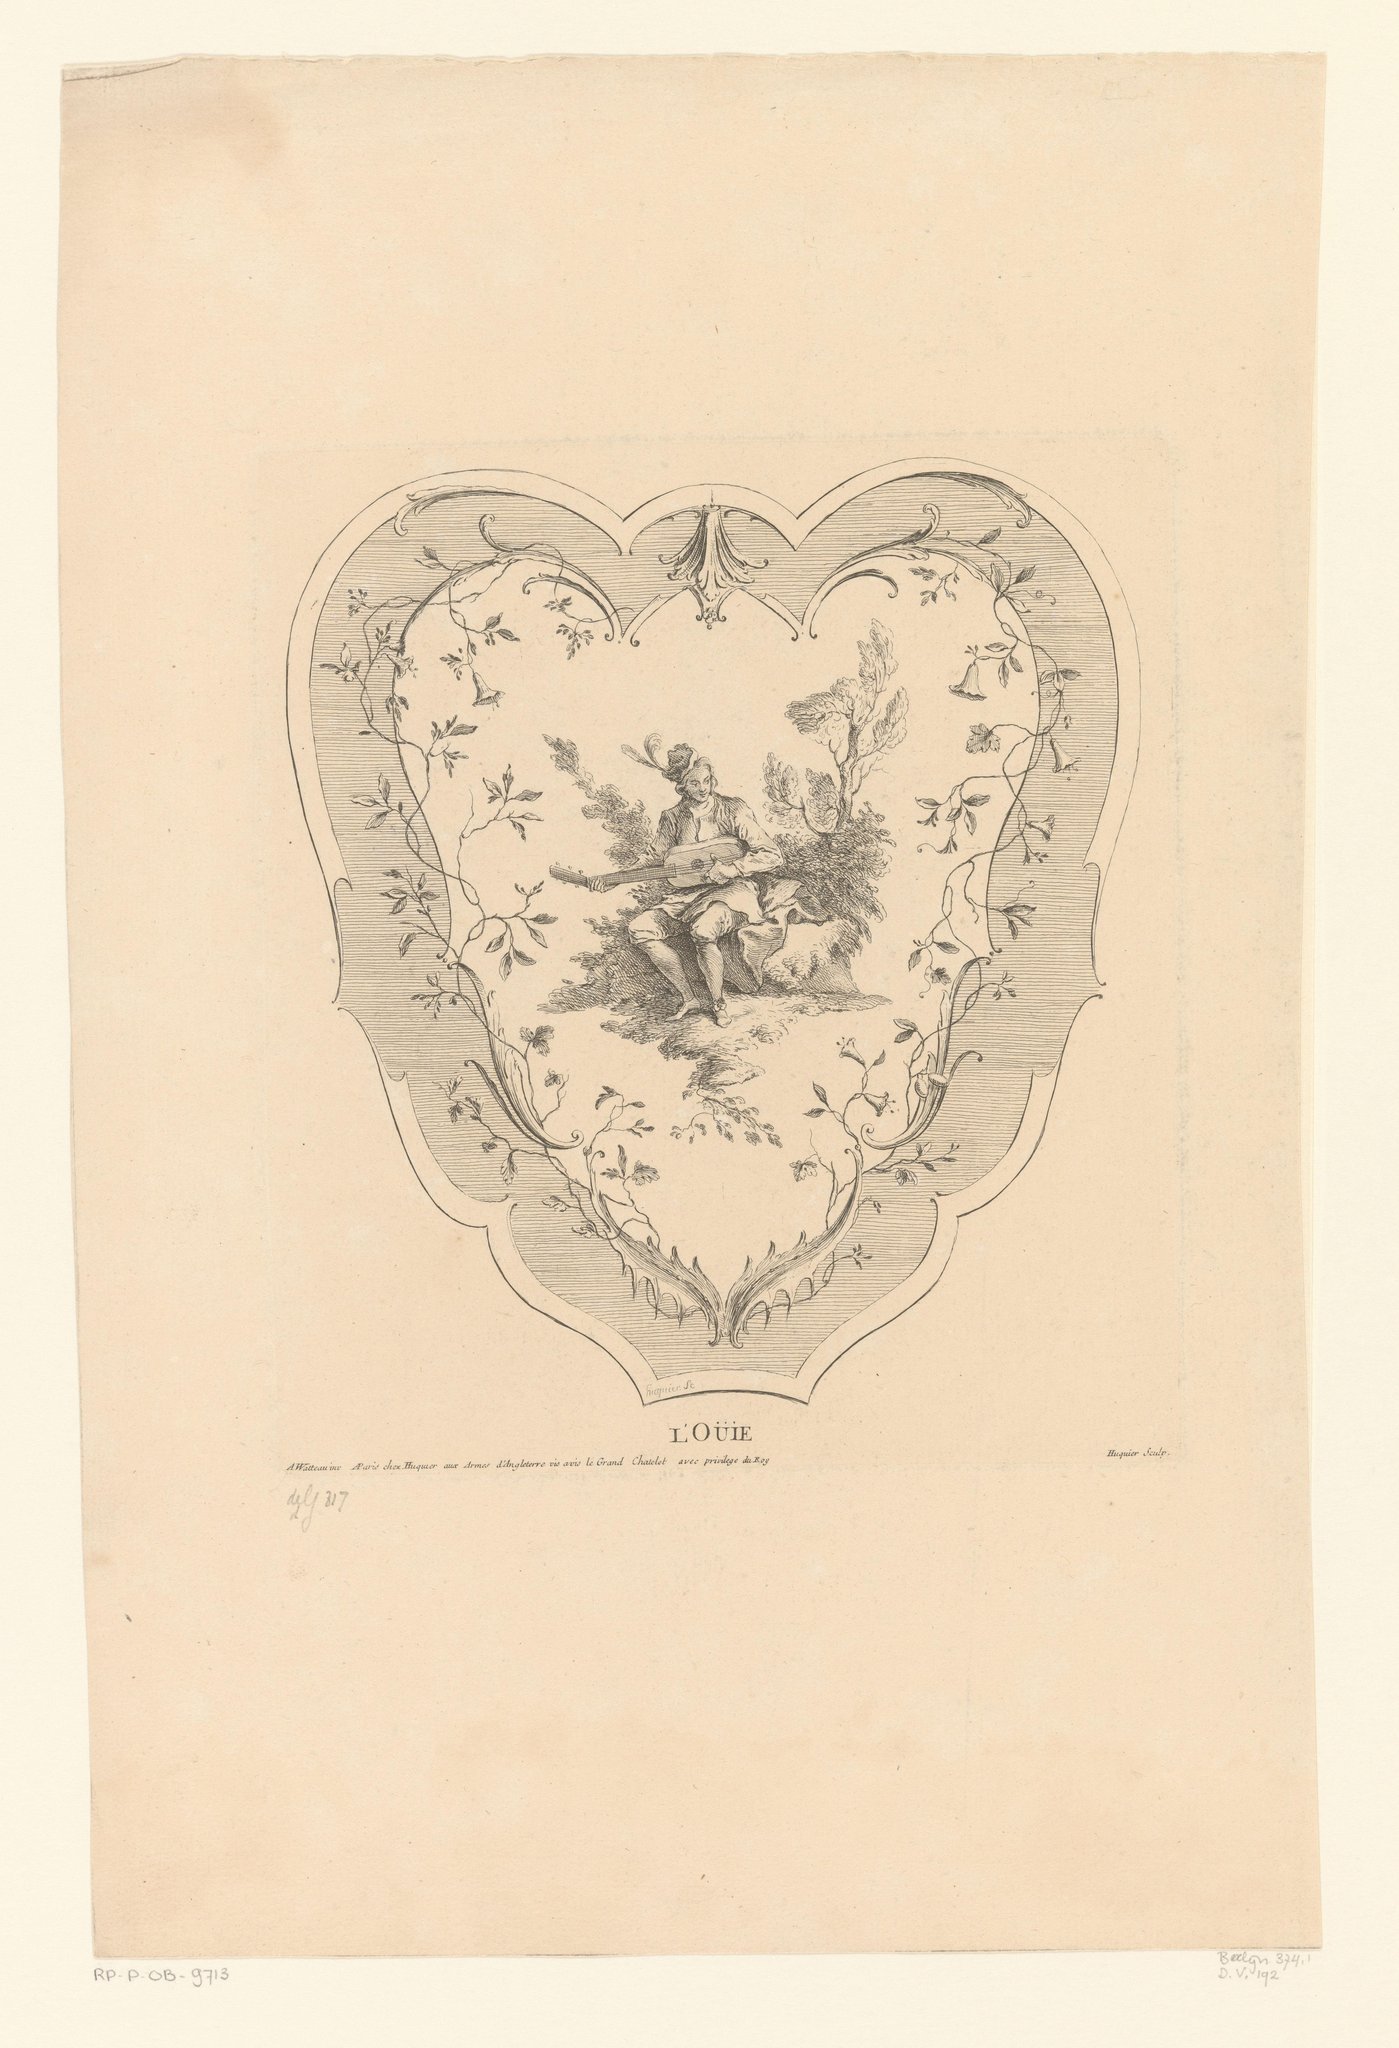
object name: ornament print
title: Gehoor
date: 1729-1737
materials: paper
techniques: etching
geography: paris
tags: 'udito' (ripa)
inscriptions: collector's mark: Lugt 2228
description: Hartvormige omlijsting met een man spelend op een luit als allegorie van het gehoor.